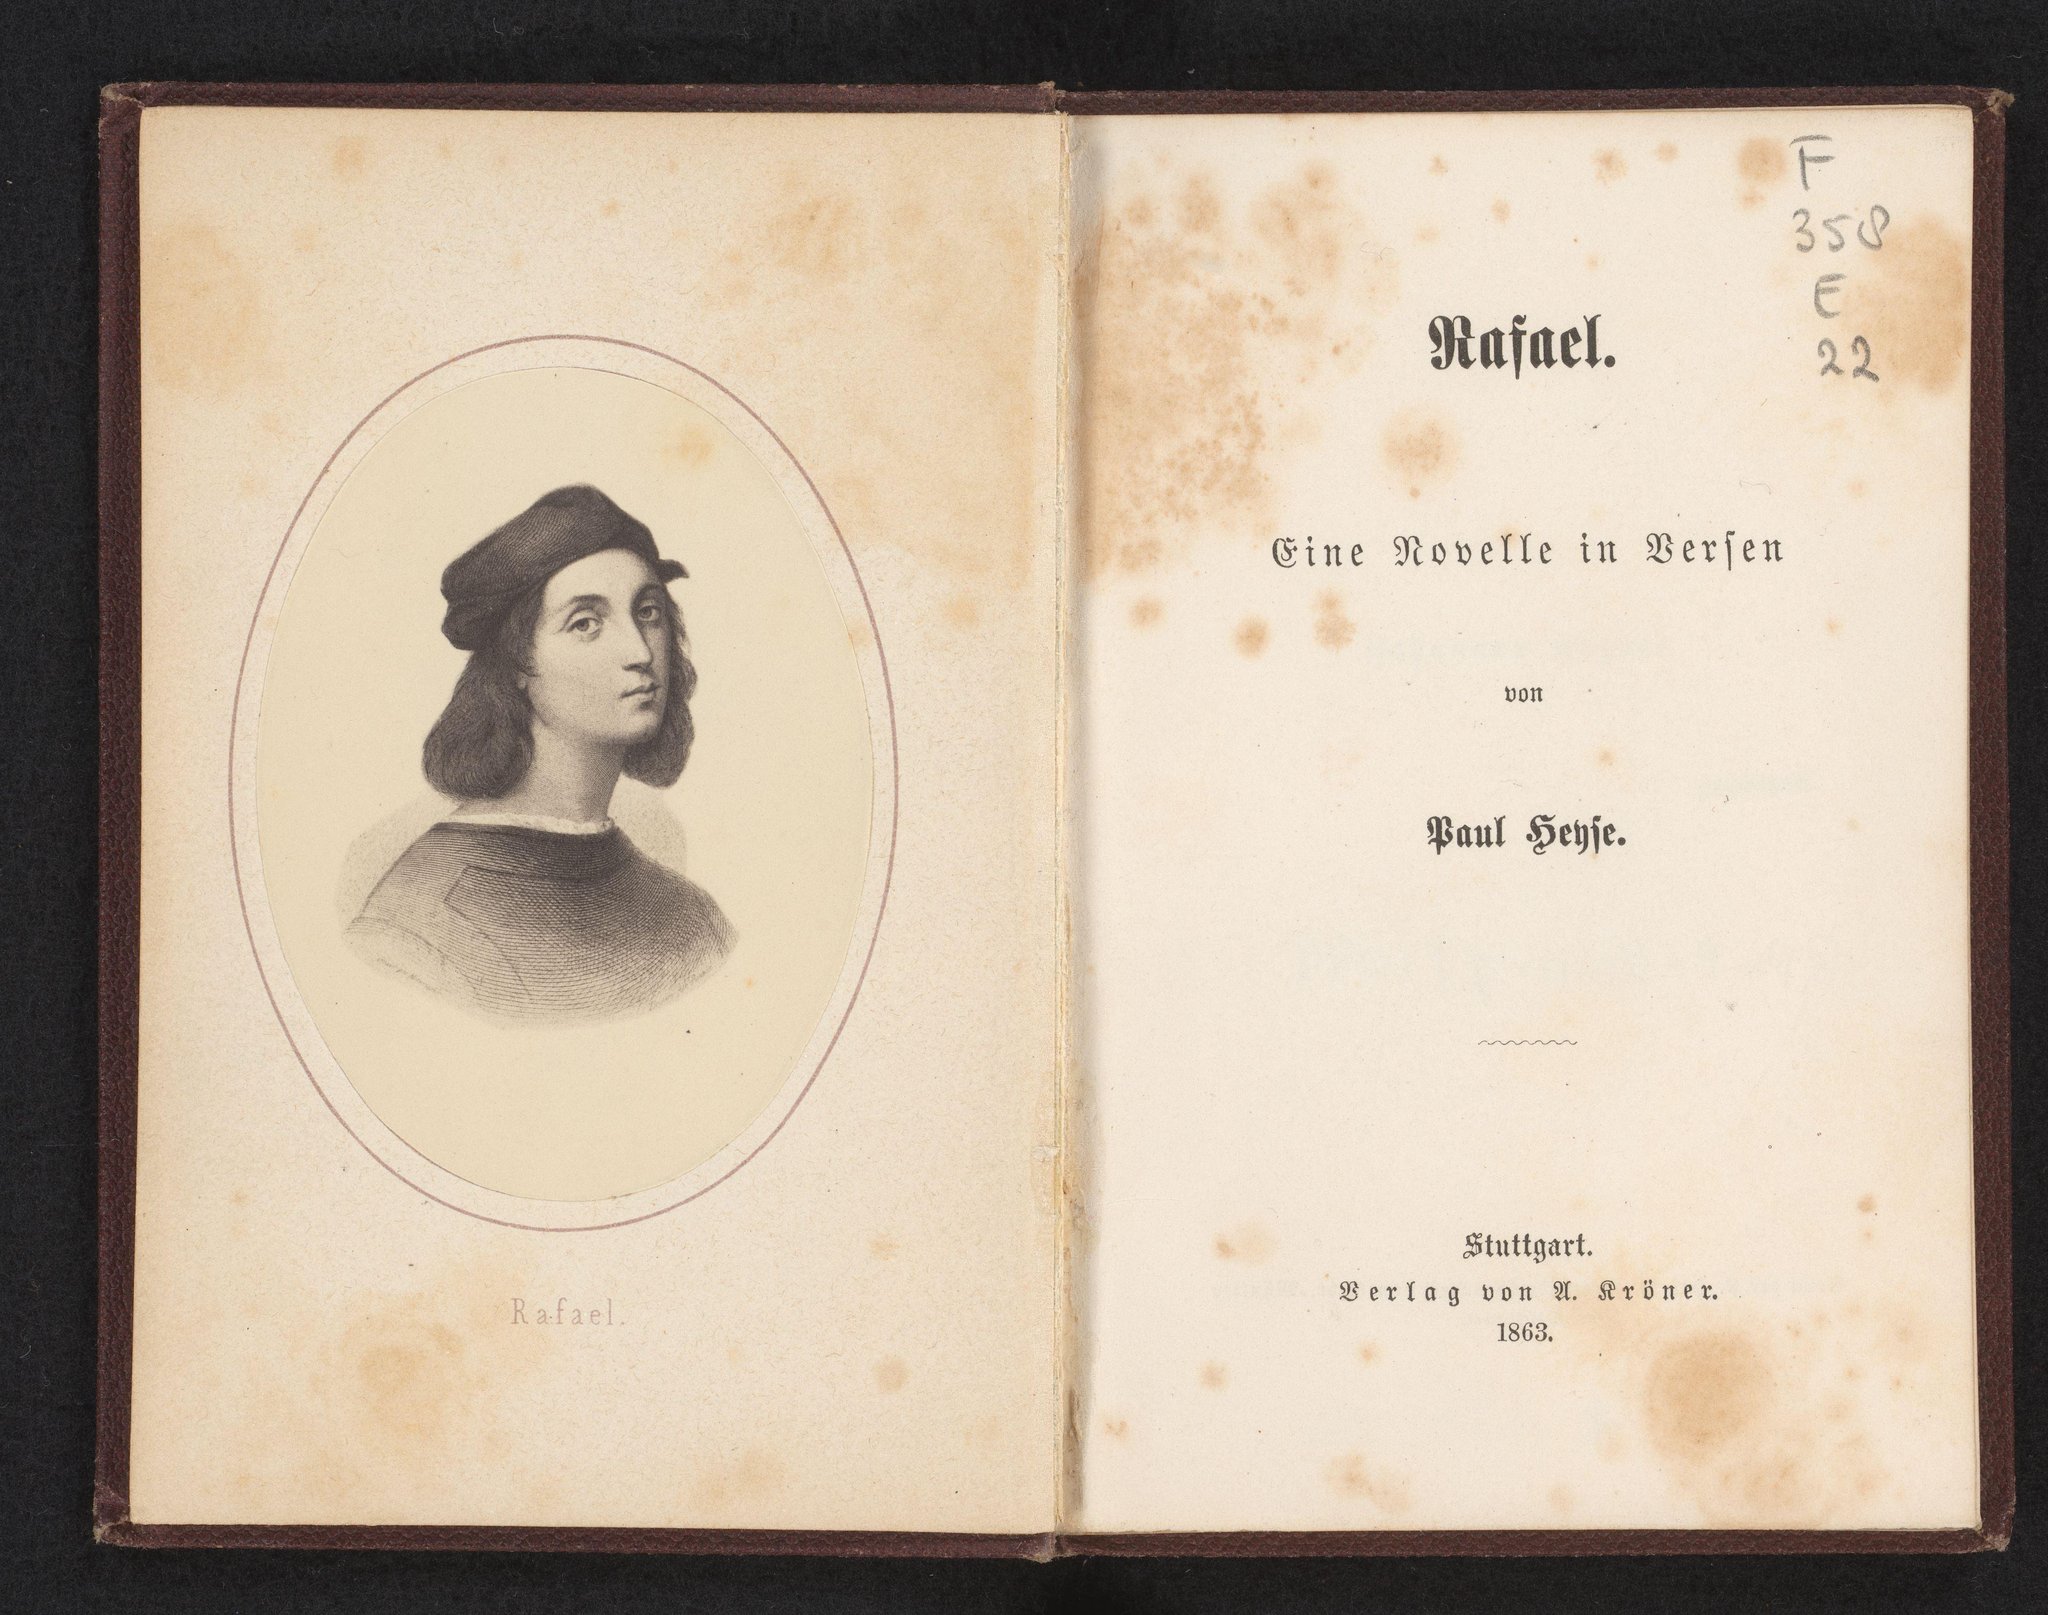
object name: book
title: Rafael : eine Novelle in Versen / von Paul Heyse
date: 1863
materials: cardboard, linen, paper, photographic support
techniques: albumen print, printing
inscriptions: date: ‘Ex-N/ 1993’